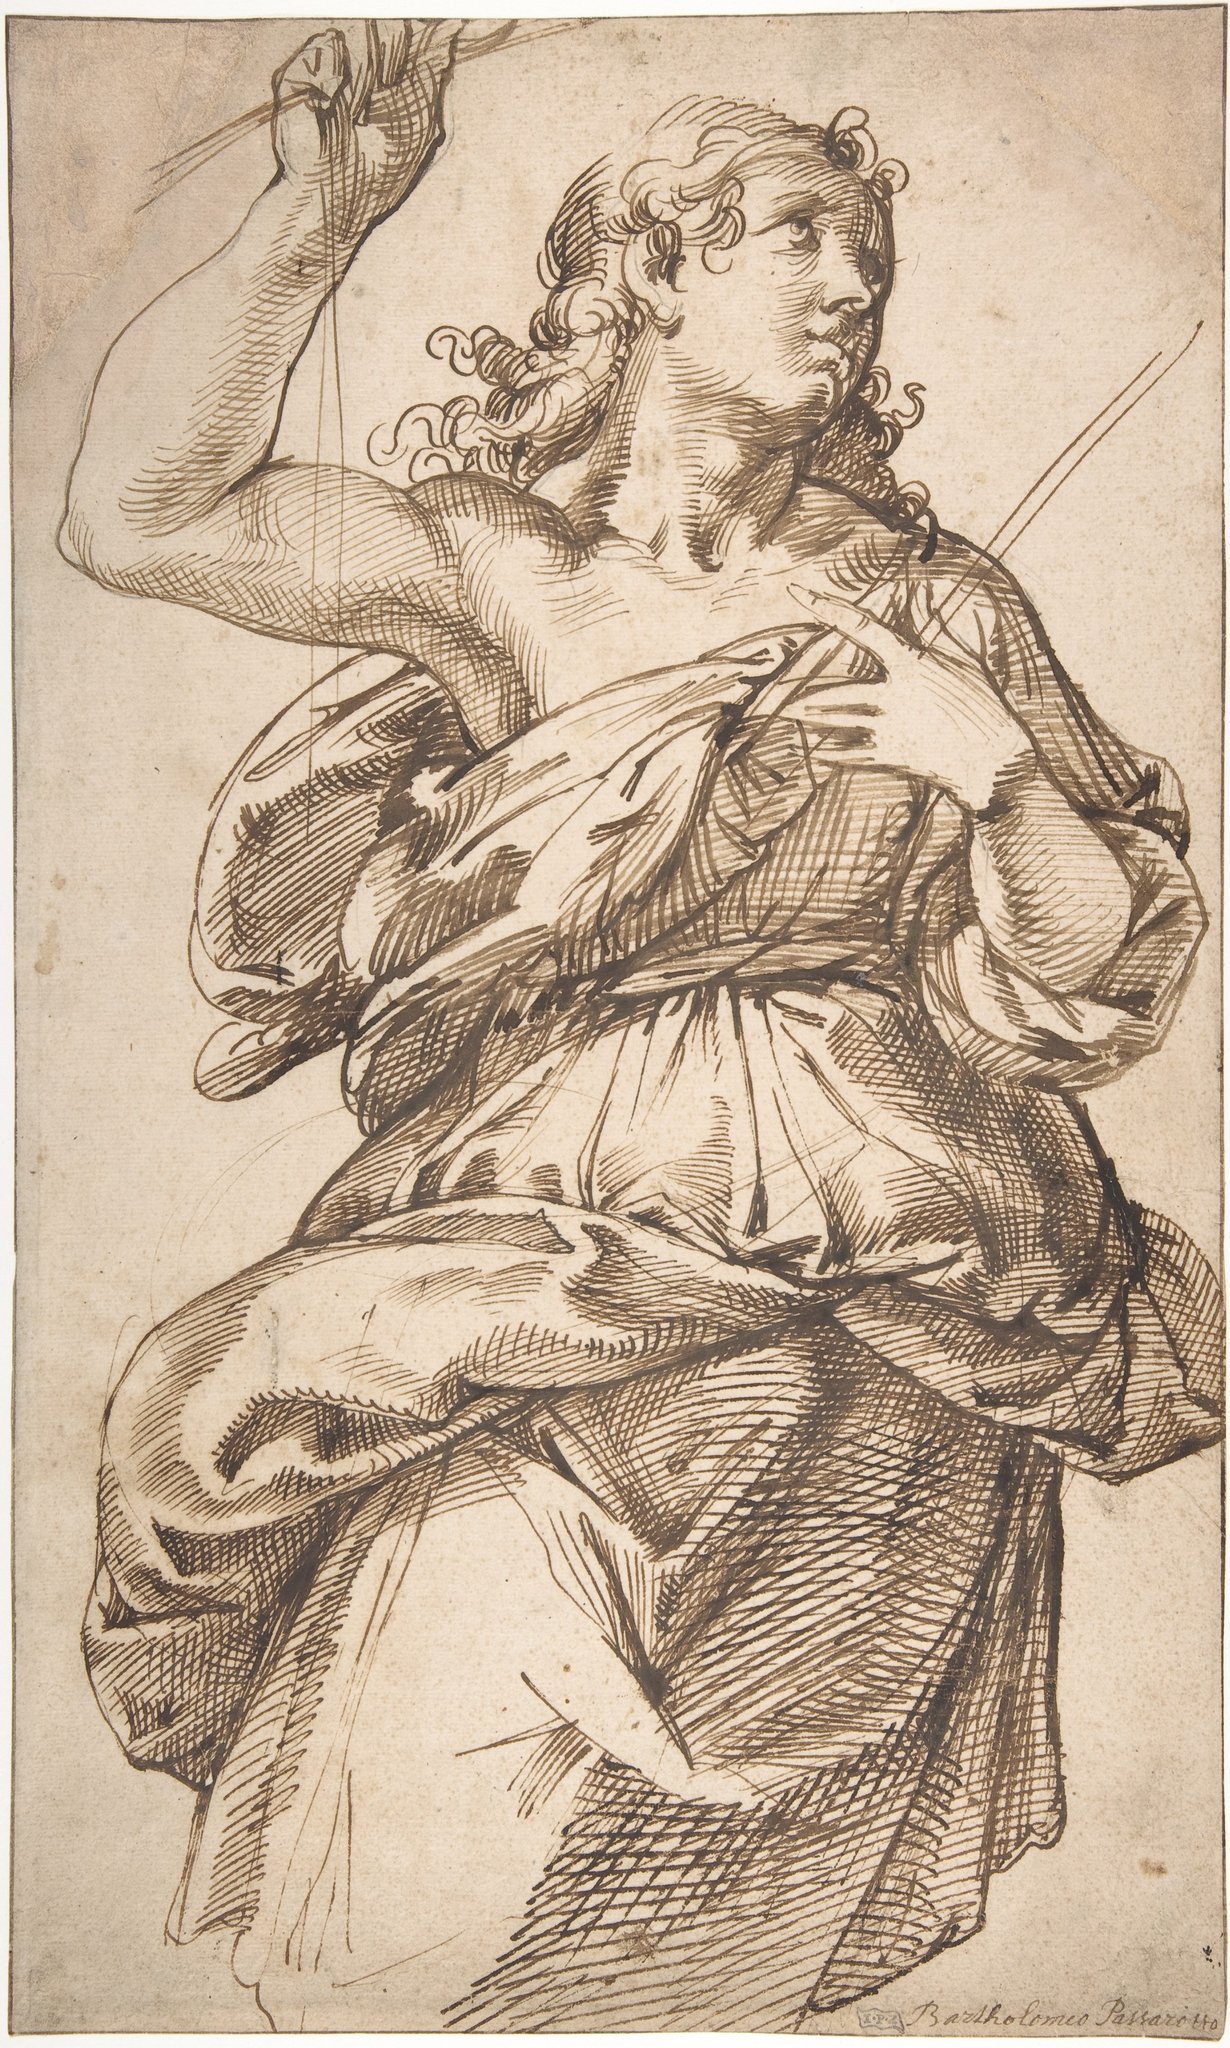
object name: drawing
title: An Angel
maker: bartolomeo passarotti (passerotti)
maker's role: artist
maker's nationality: italian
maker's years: 1529-1592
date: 1529-1592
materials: chalk, ink, paper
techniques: pen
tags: angels